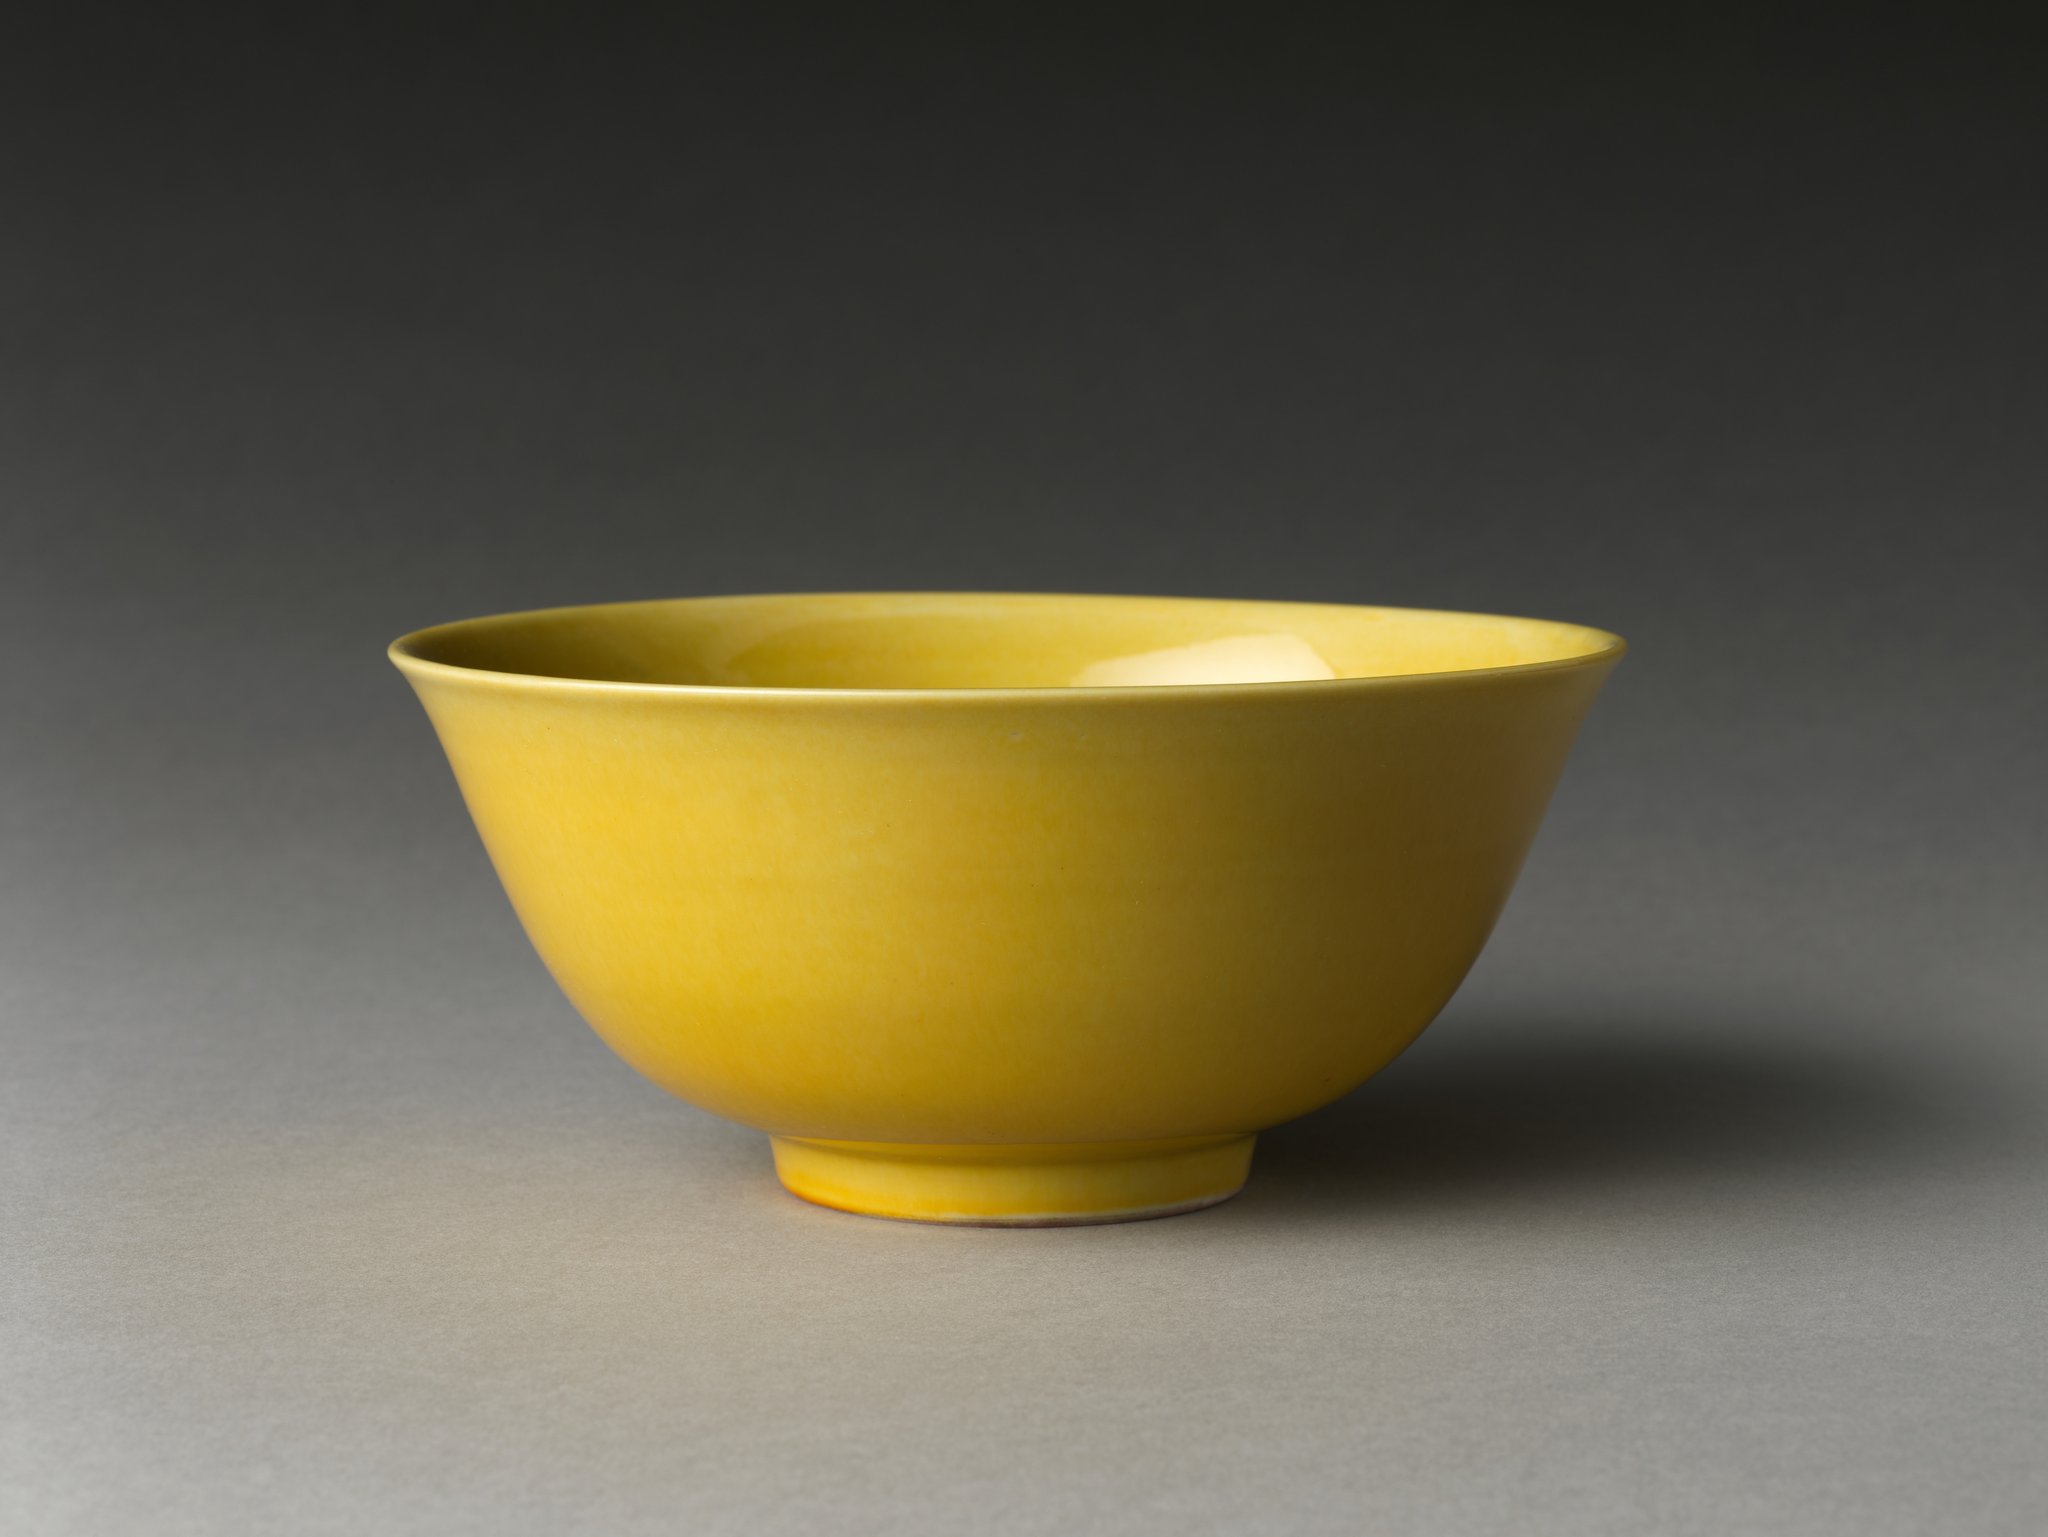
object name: bowl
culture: chinese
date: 1534-1566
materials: glaze, porcelain